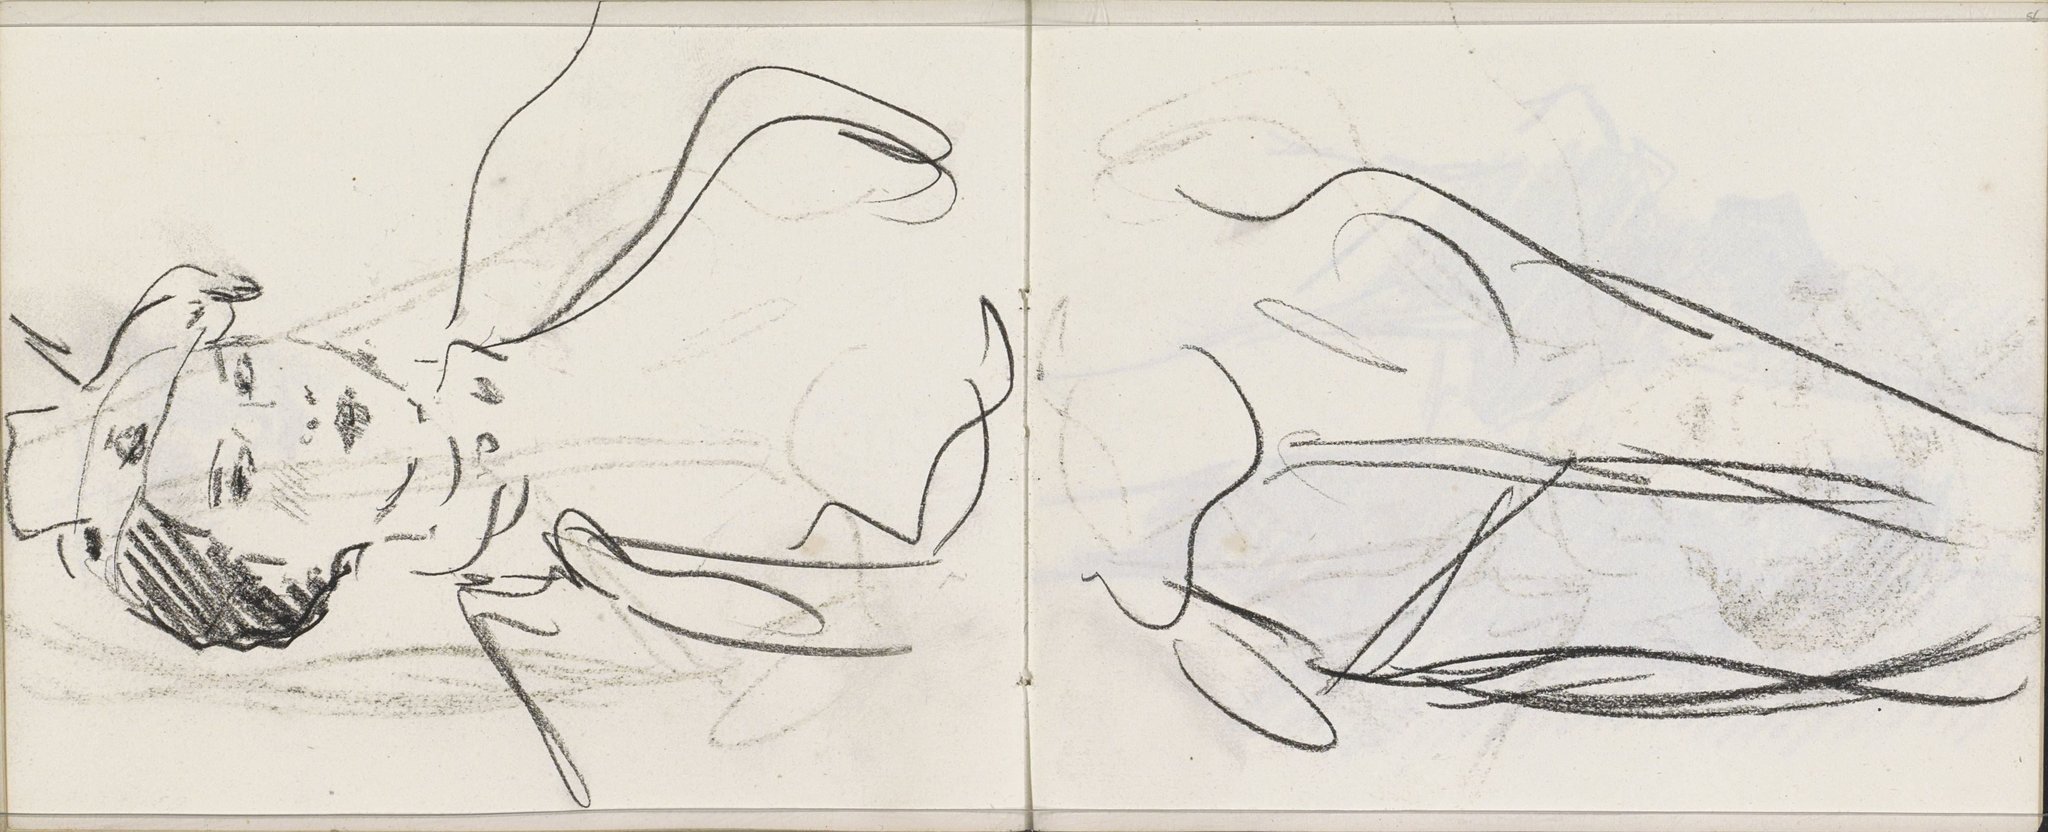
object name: sketchbook leaf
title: Staande vrouw met hoed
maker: isaac israels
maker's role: draughtsman, painter, print maker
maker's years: 1865-1934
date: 1875-1934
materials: chalk, paper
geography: the hague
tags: head-gear: hat (+ women's clothes), adult woman (+ standing)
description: Pagina 55 en pagina 56 uit schetsboek XLIII met 61 pagina's.